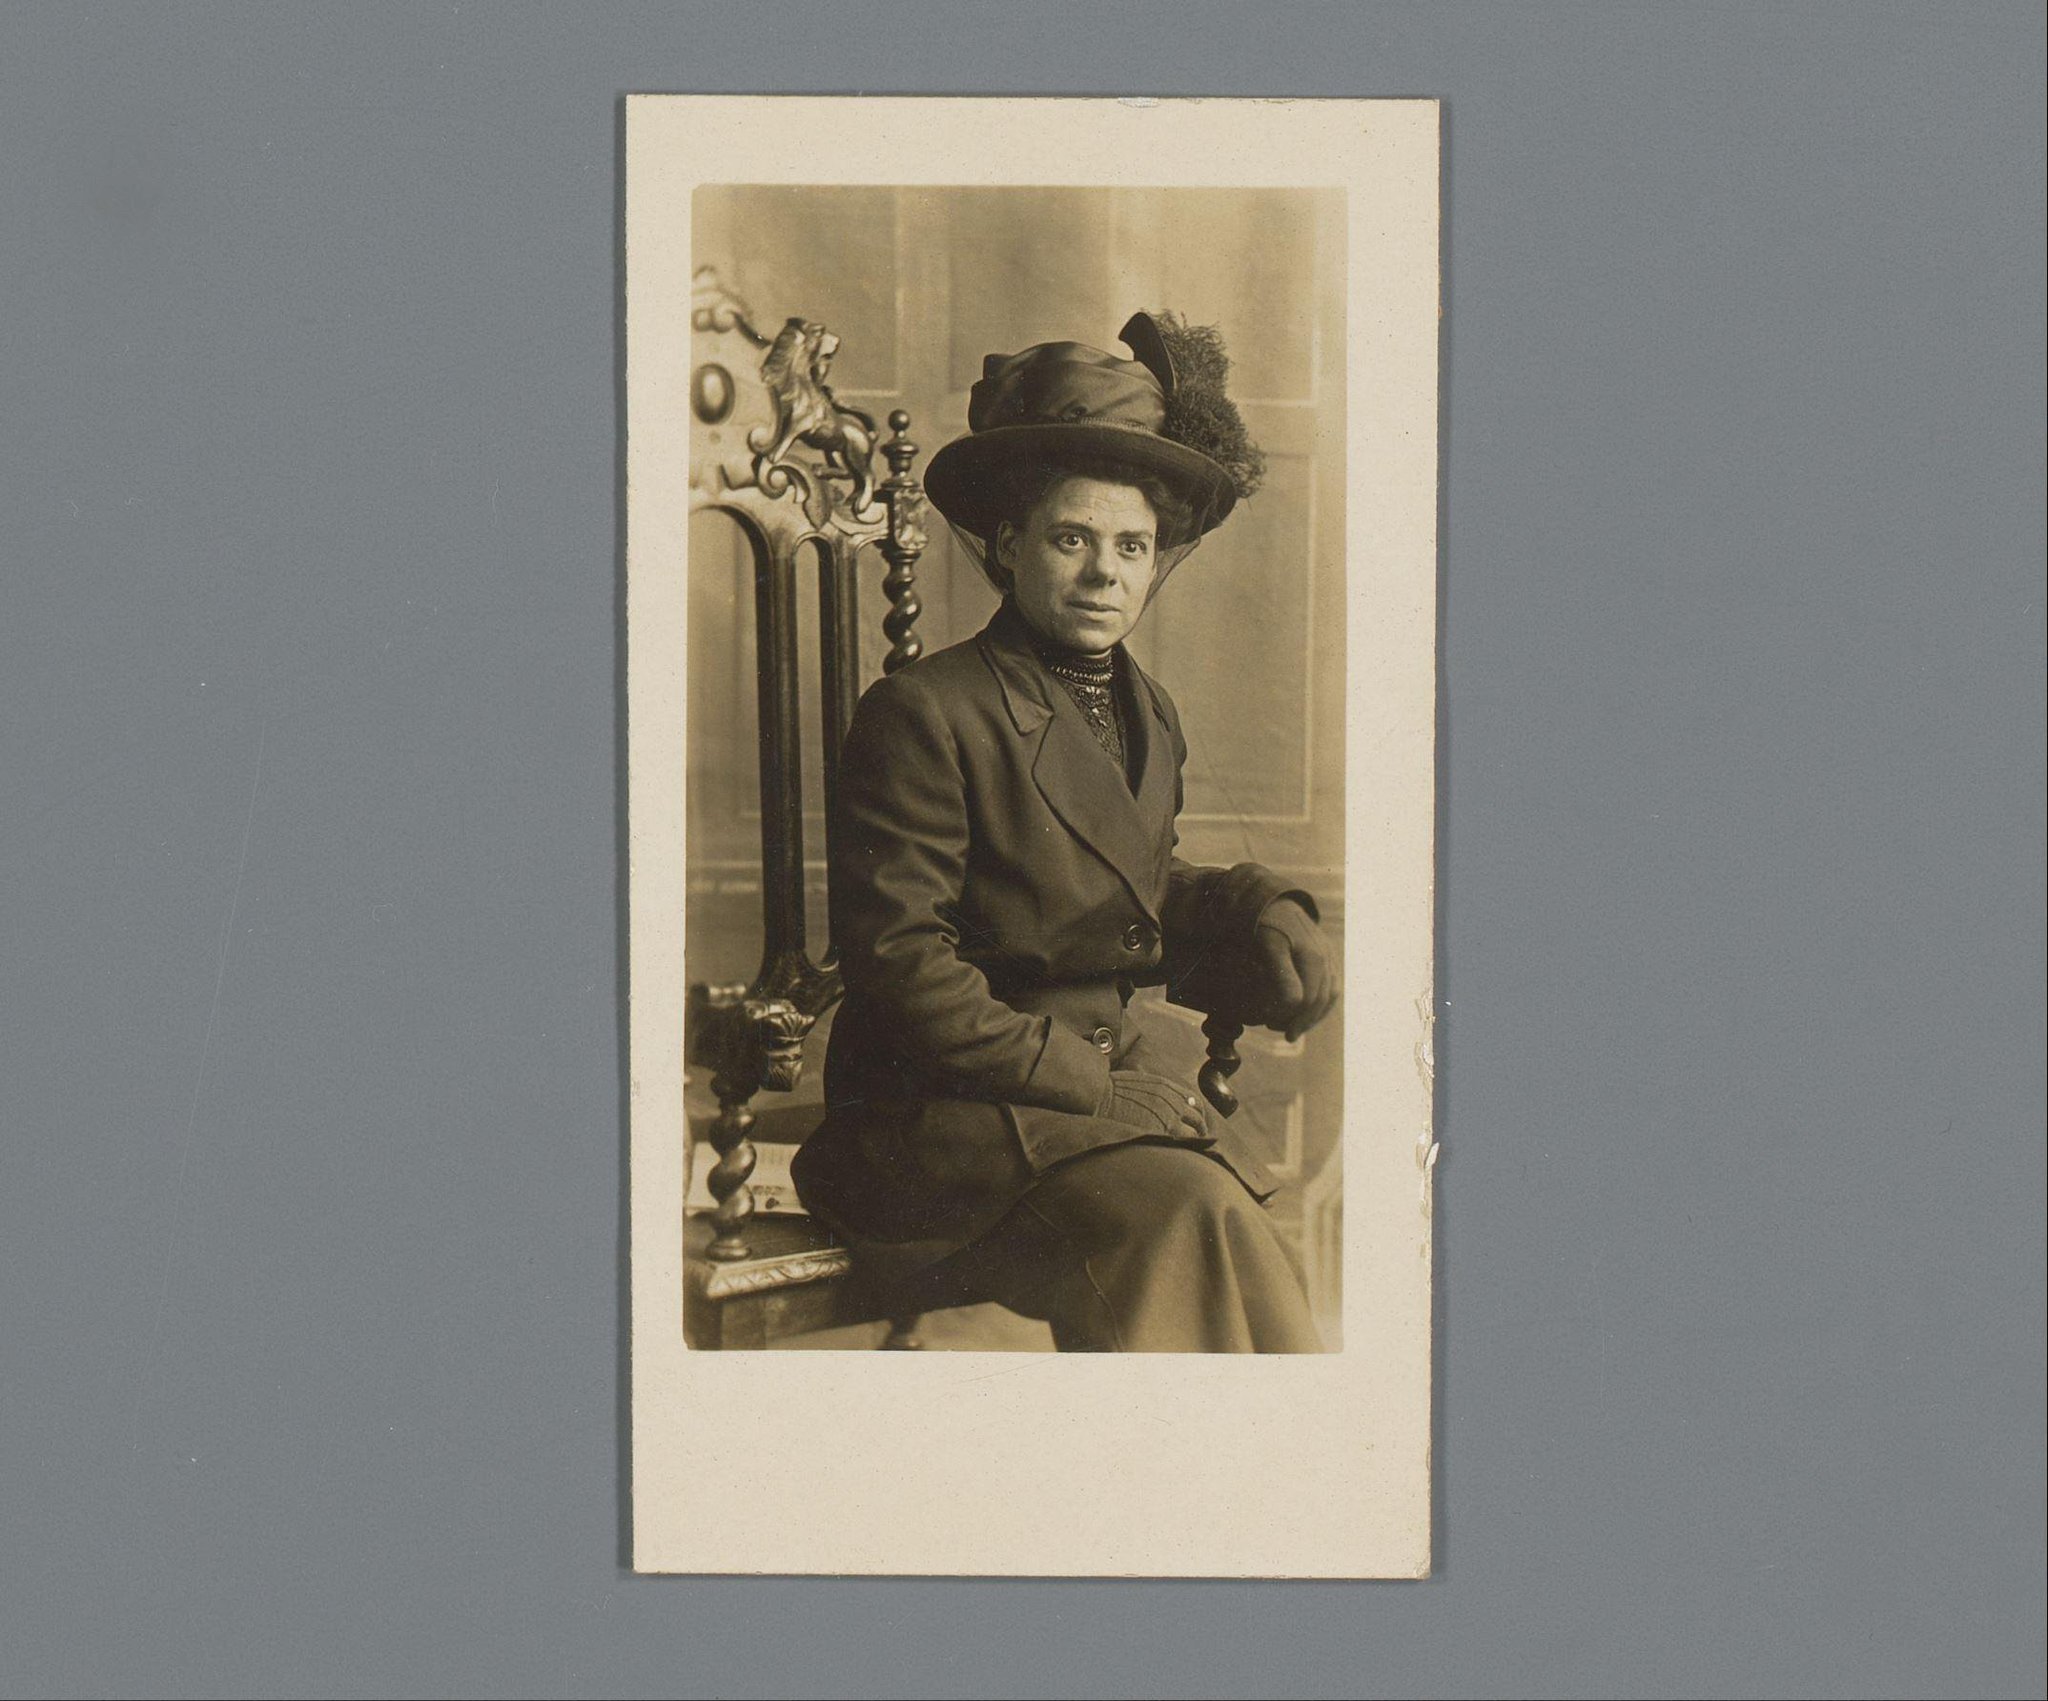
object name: photograph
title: Portret van een onbekende vrouw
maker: Anonymous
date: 1910-1930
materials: paper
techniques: gelatin silver print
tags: adult woman, anonymous historical person portrayed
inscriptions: inscription: ‘uit Engels album.’